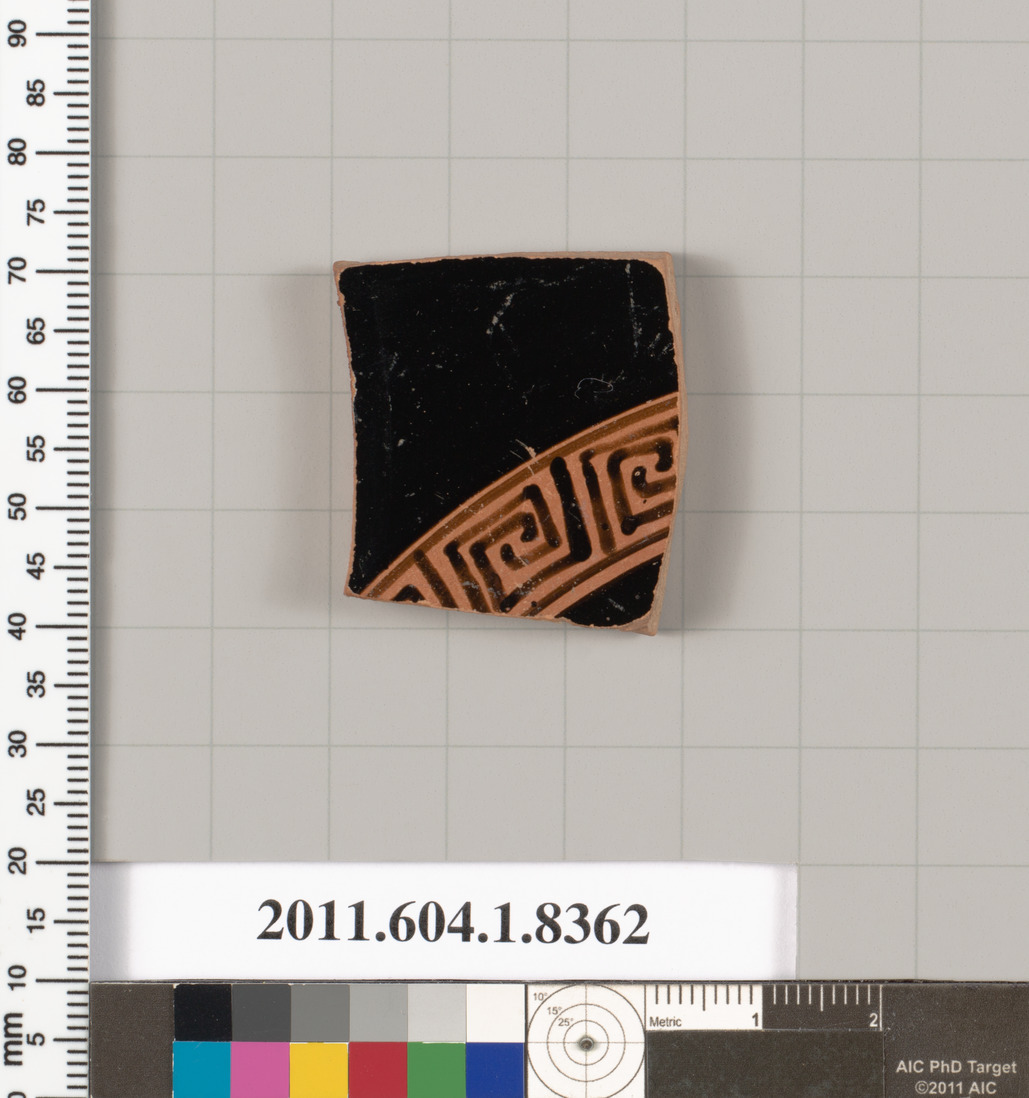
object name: kylix fragment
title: Terracotta fragment of a kylix (drinking cup)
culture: greek, attic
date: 425-401 BCE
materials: terracotta